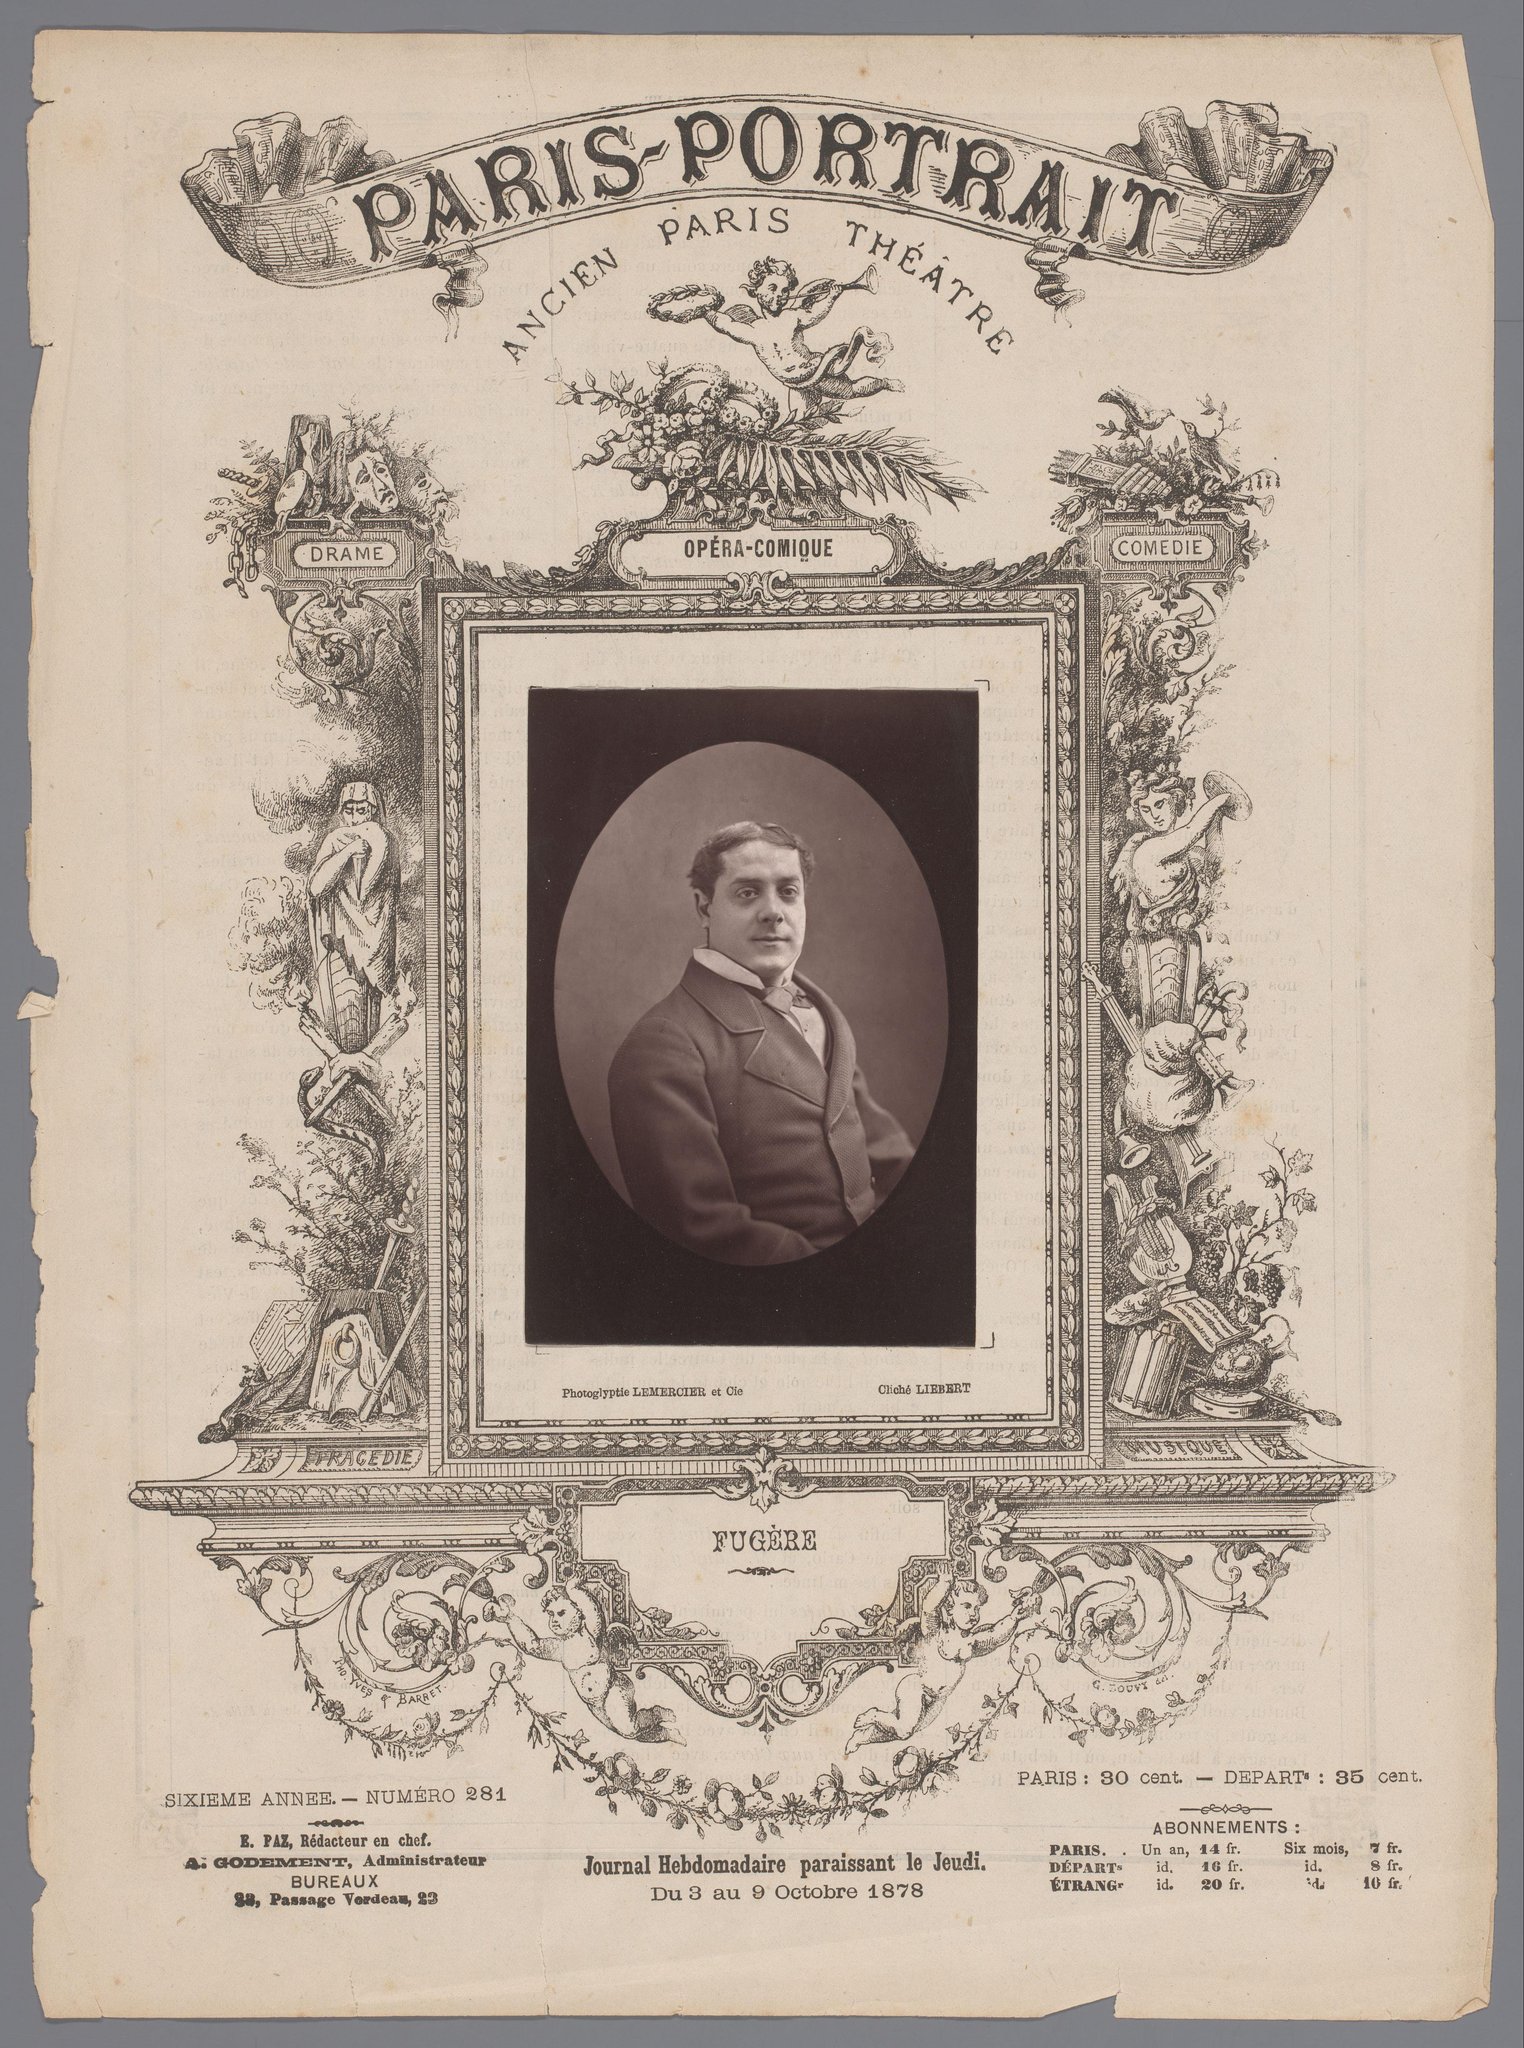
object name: photograph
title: Portret van Lucien Fugère (1854-?), Frans acteur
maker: alphonse-justin liébert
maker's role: fotograaf, marinier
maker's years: 1827-1914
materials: paper, photographic support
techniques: woodburytype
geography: paris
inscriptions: inscription: ‘FUGÈRE’, inscription: ‘PARIS-PORTRAIT//Ancien Paris Théatre’, inscription: ‘Cliché LIEBERT’, inscription, inscription: ‘Photoglyptie LEMERCIER et Cie’